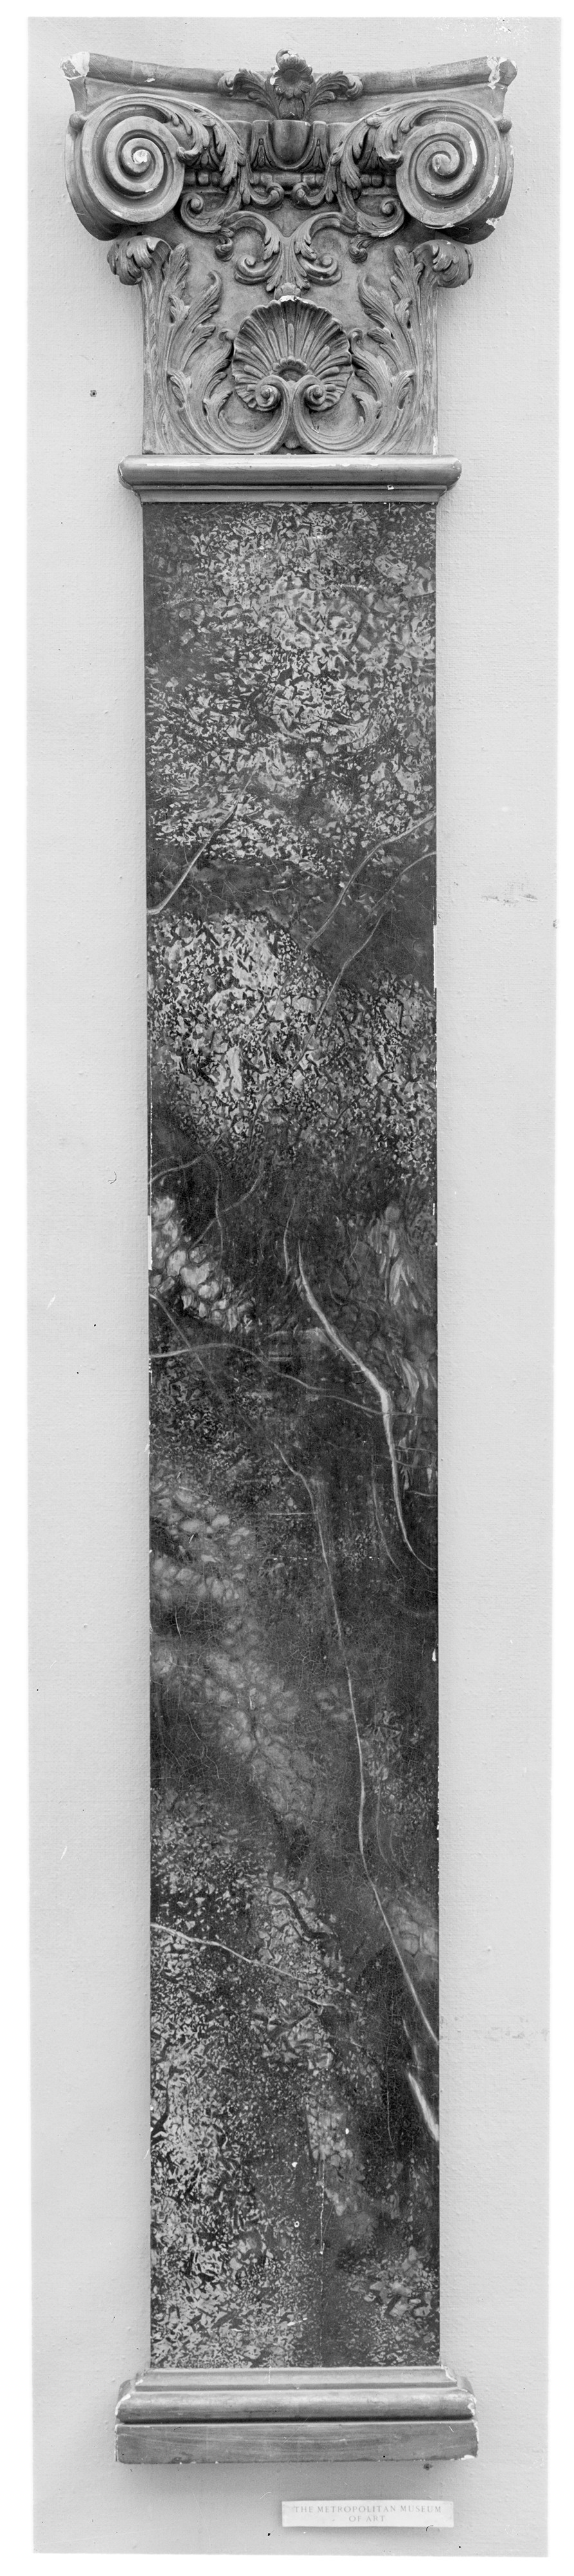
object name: pilaster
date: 1601-1700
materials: marble, wood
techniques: carving, gilding, painting